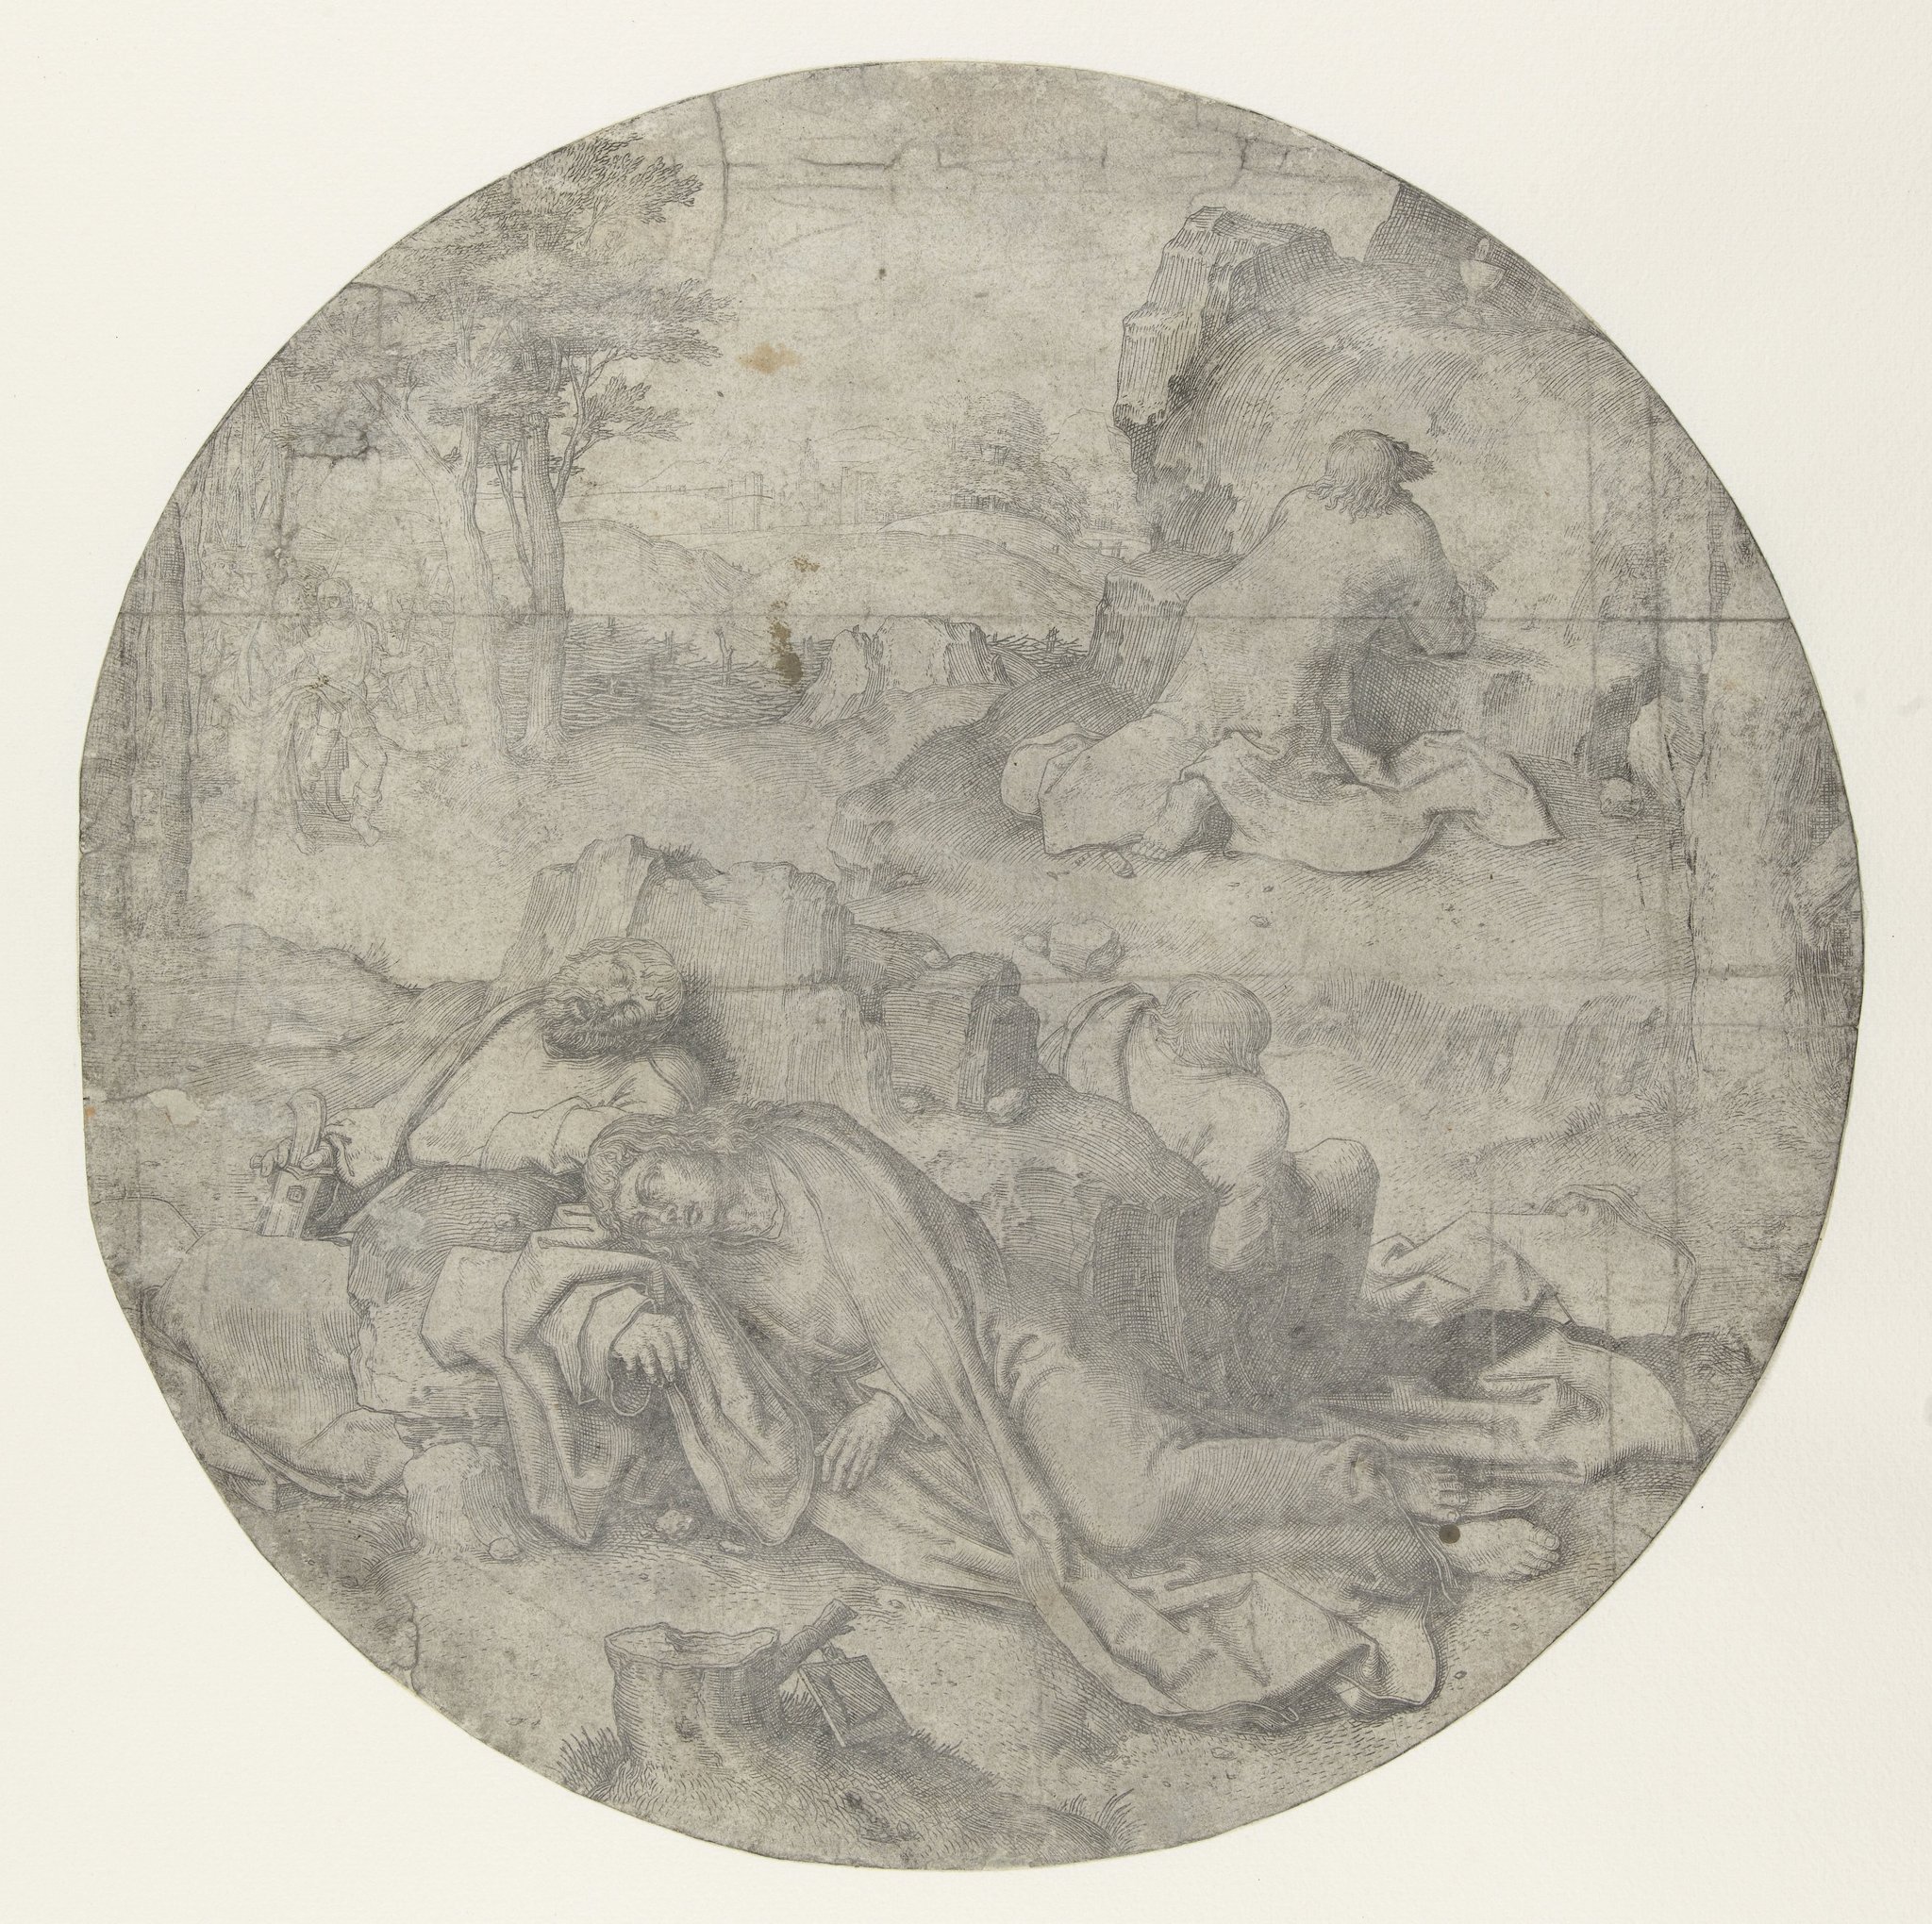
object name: print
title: Christus op de olijfberg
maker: lucas van leyden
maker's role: draughtsman, painter, print maker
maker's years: 1494-1533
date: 1509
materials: paper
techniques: engraving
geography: low countries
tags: christ's prayer in the garden of gethsemane during the night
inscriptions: collector's mark: Lugt 2228a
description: Omlijsting weggesneden. Drie slapende apostelen en Christus biddend op de berg. Op een rots boven hem een kelk.